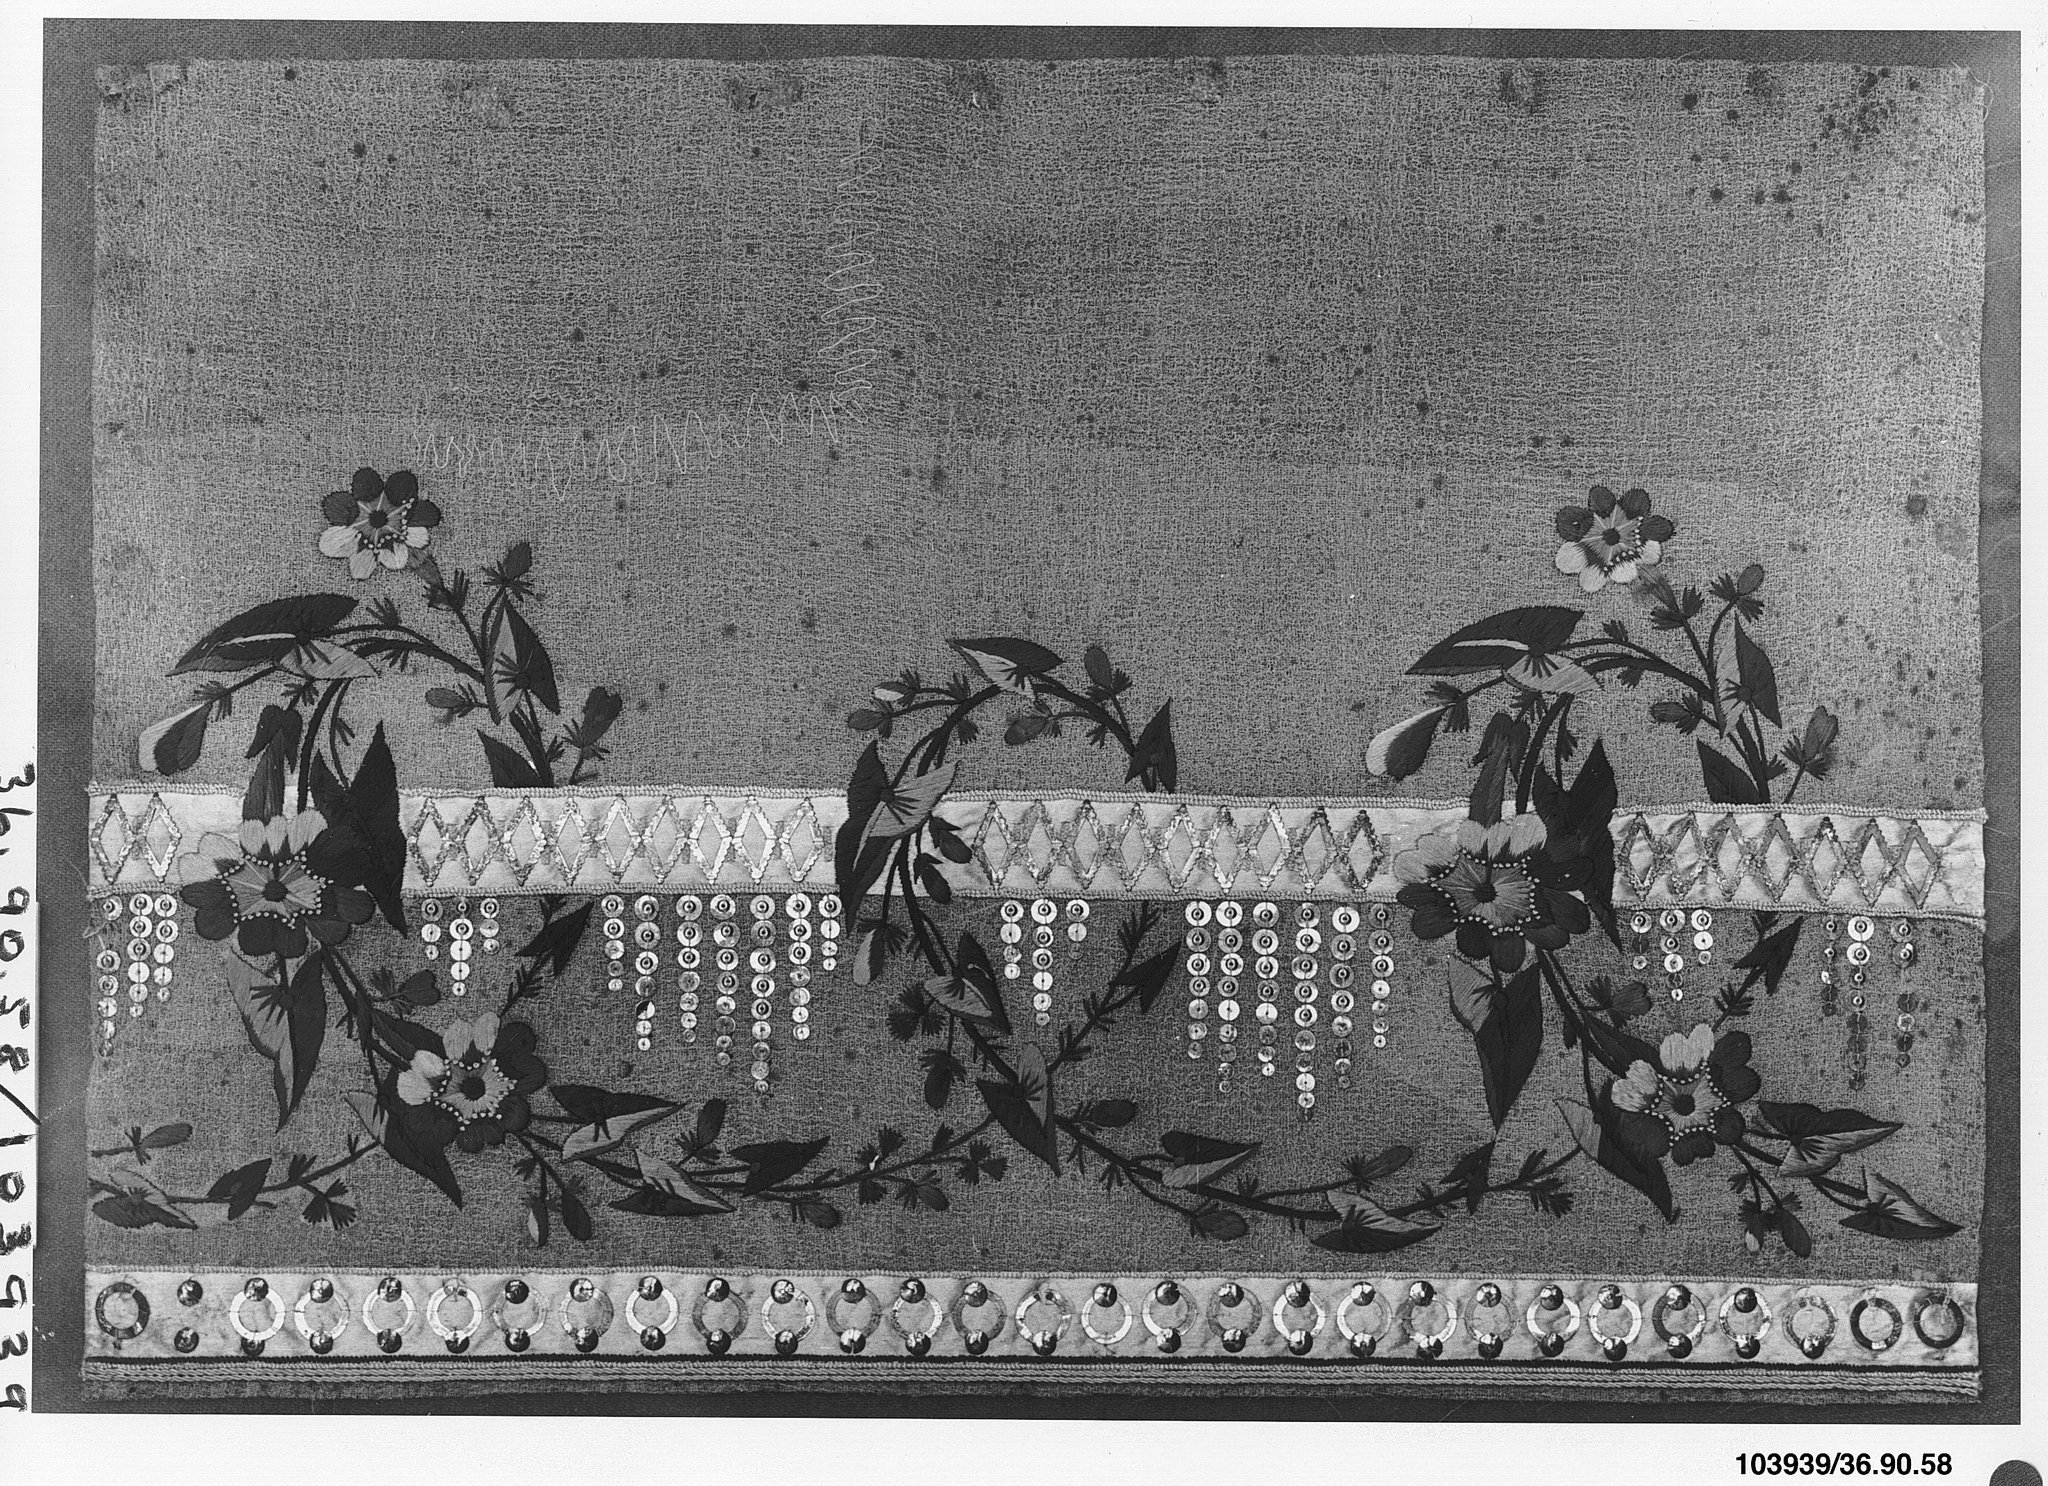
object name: border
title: Dress border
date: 1801-1900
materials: silk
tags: flowers